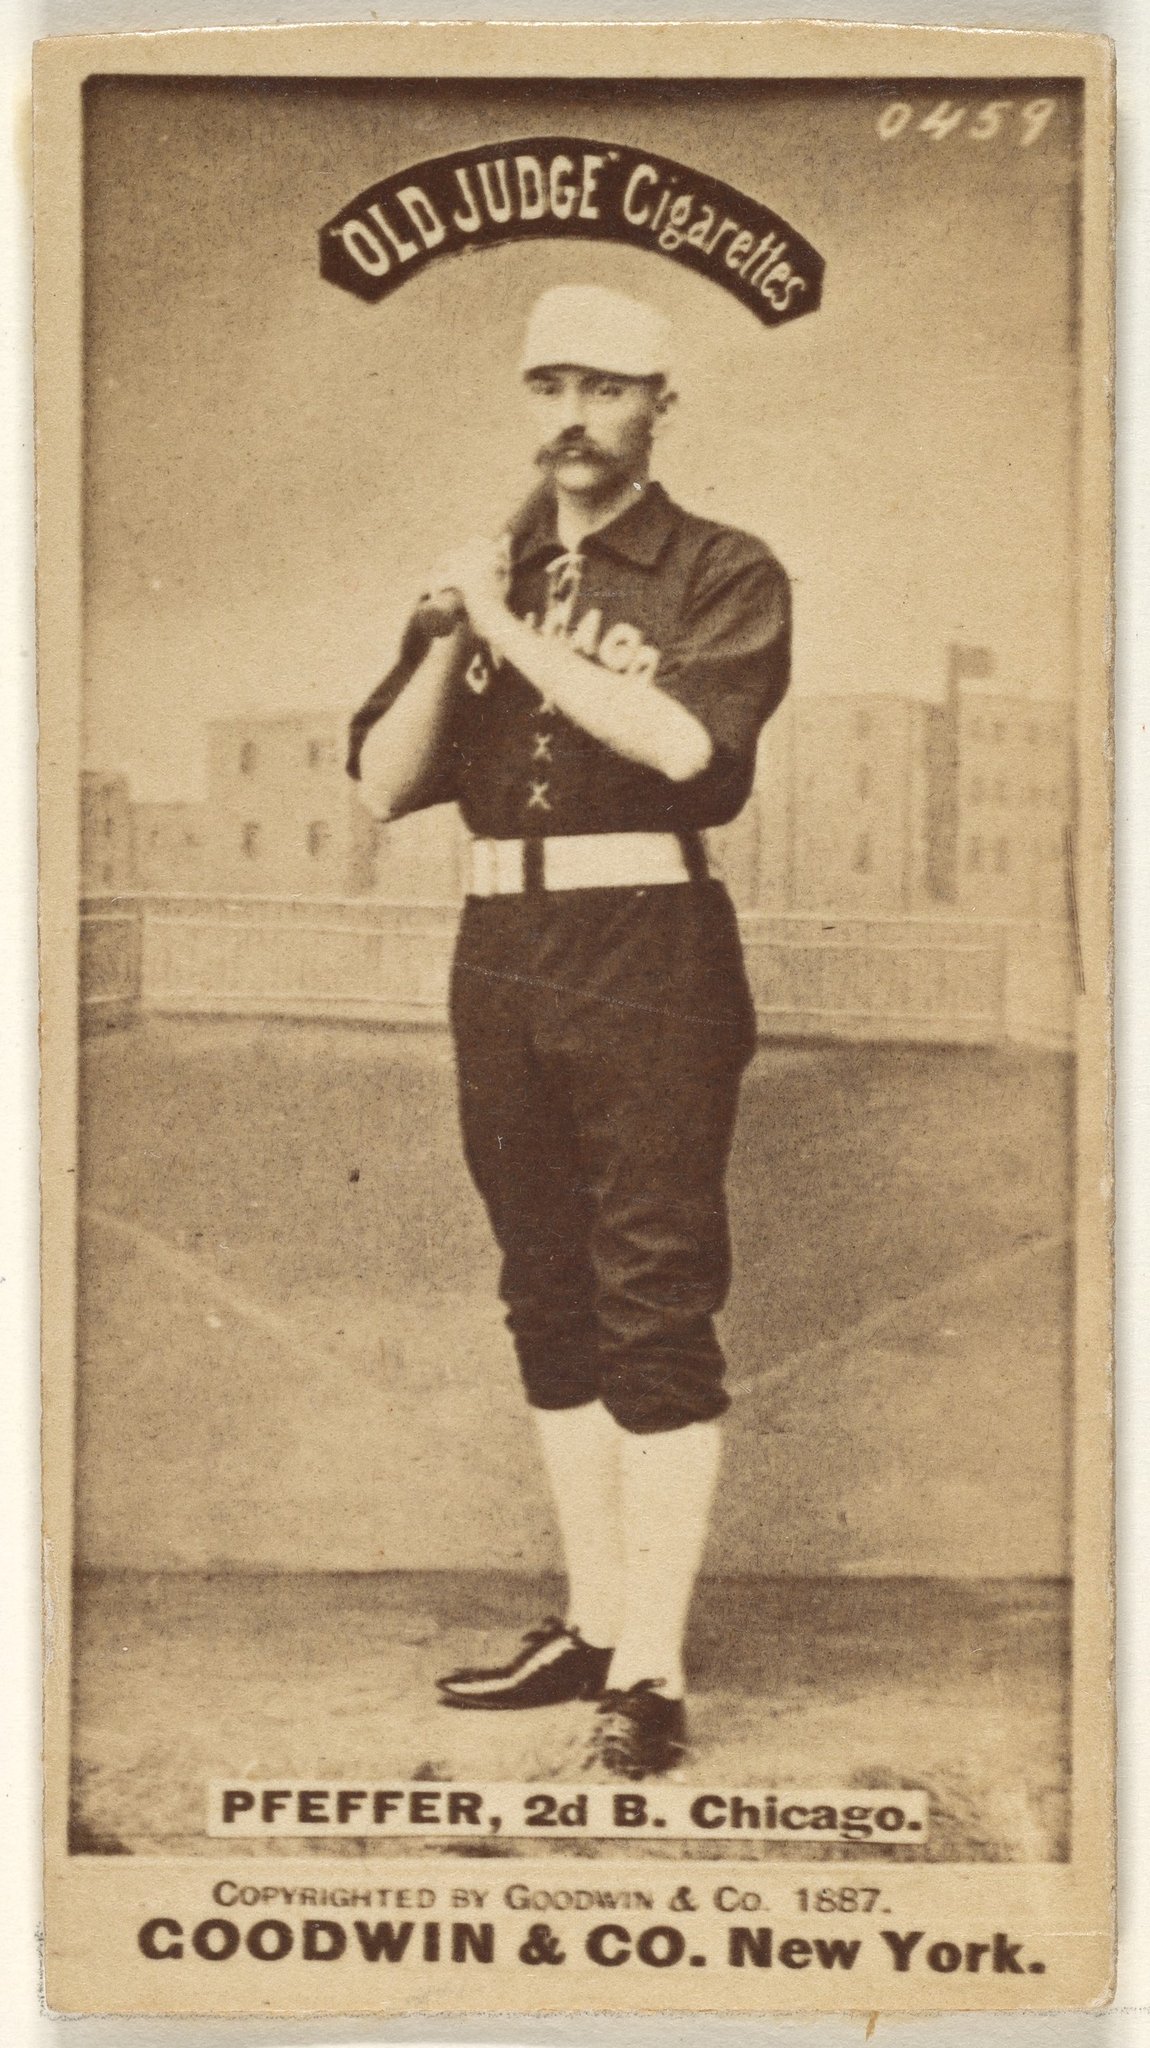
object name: baseball card, photograph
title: Fred "Dandelion" Pfeffer, 2nd Base, Chicago, from the Old Judge series (N172) for Old Judge Cigarettes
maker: goodwin & company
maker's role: publisher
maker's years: 1850-1950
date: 1887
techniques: albumen silver print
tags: men,portraits,baseball,athletes